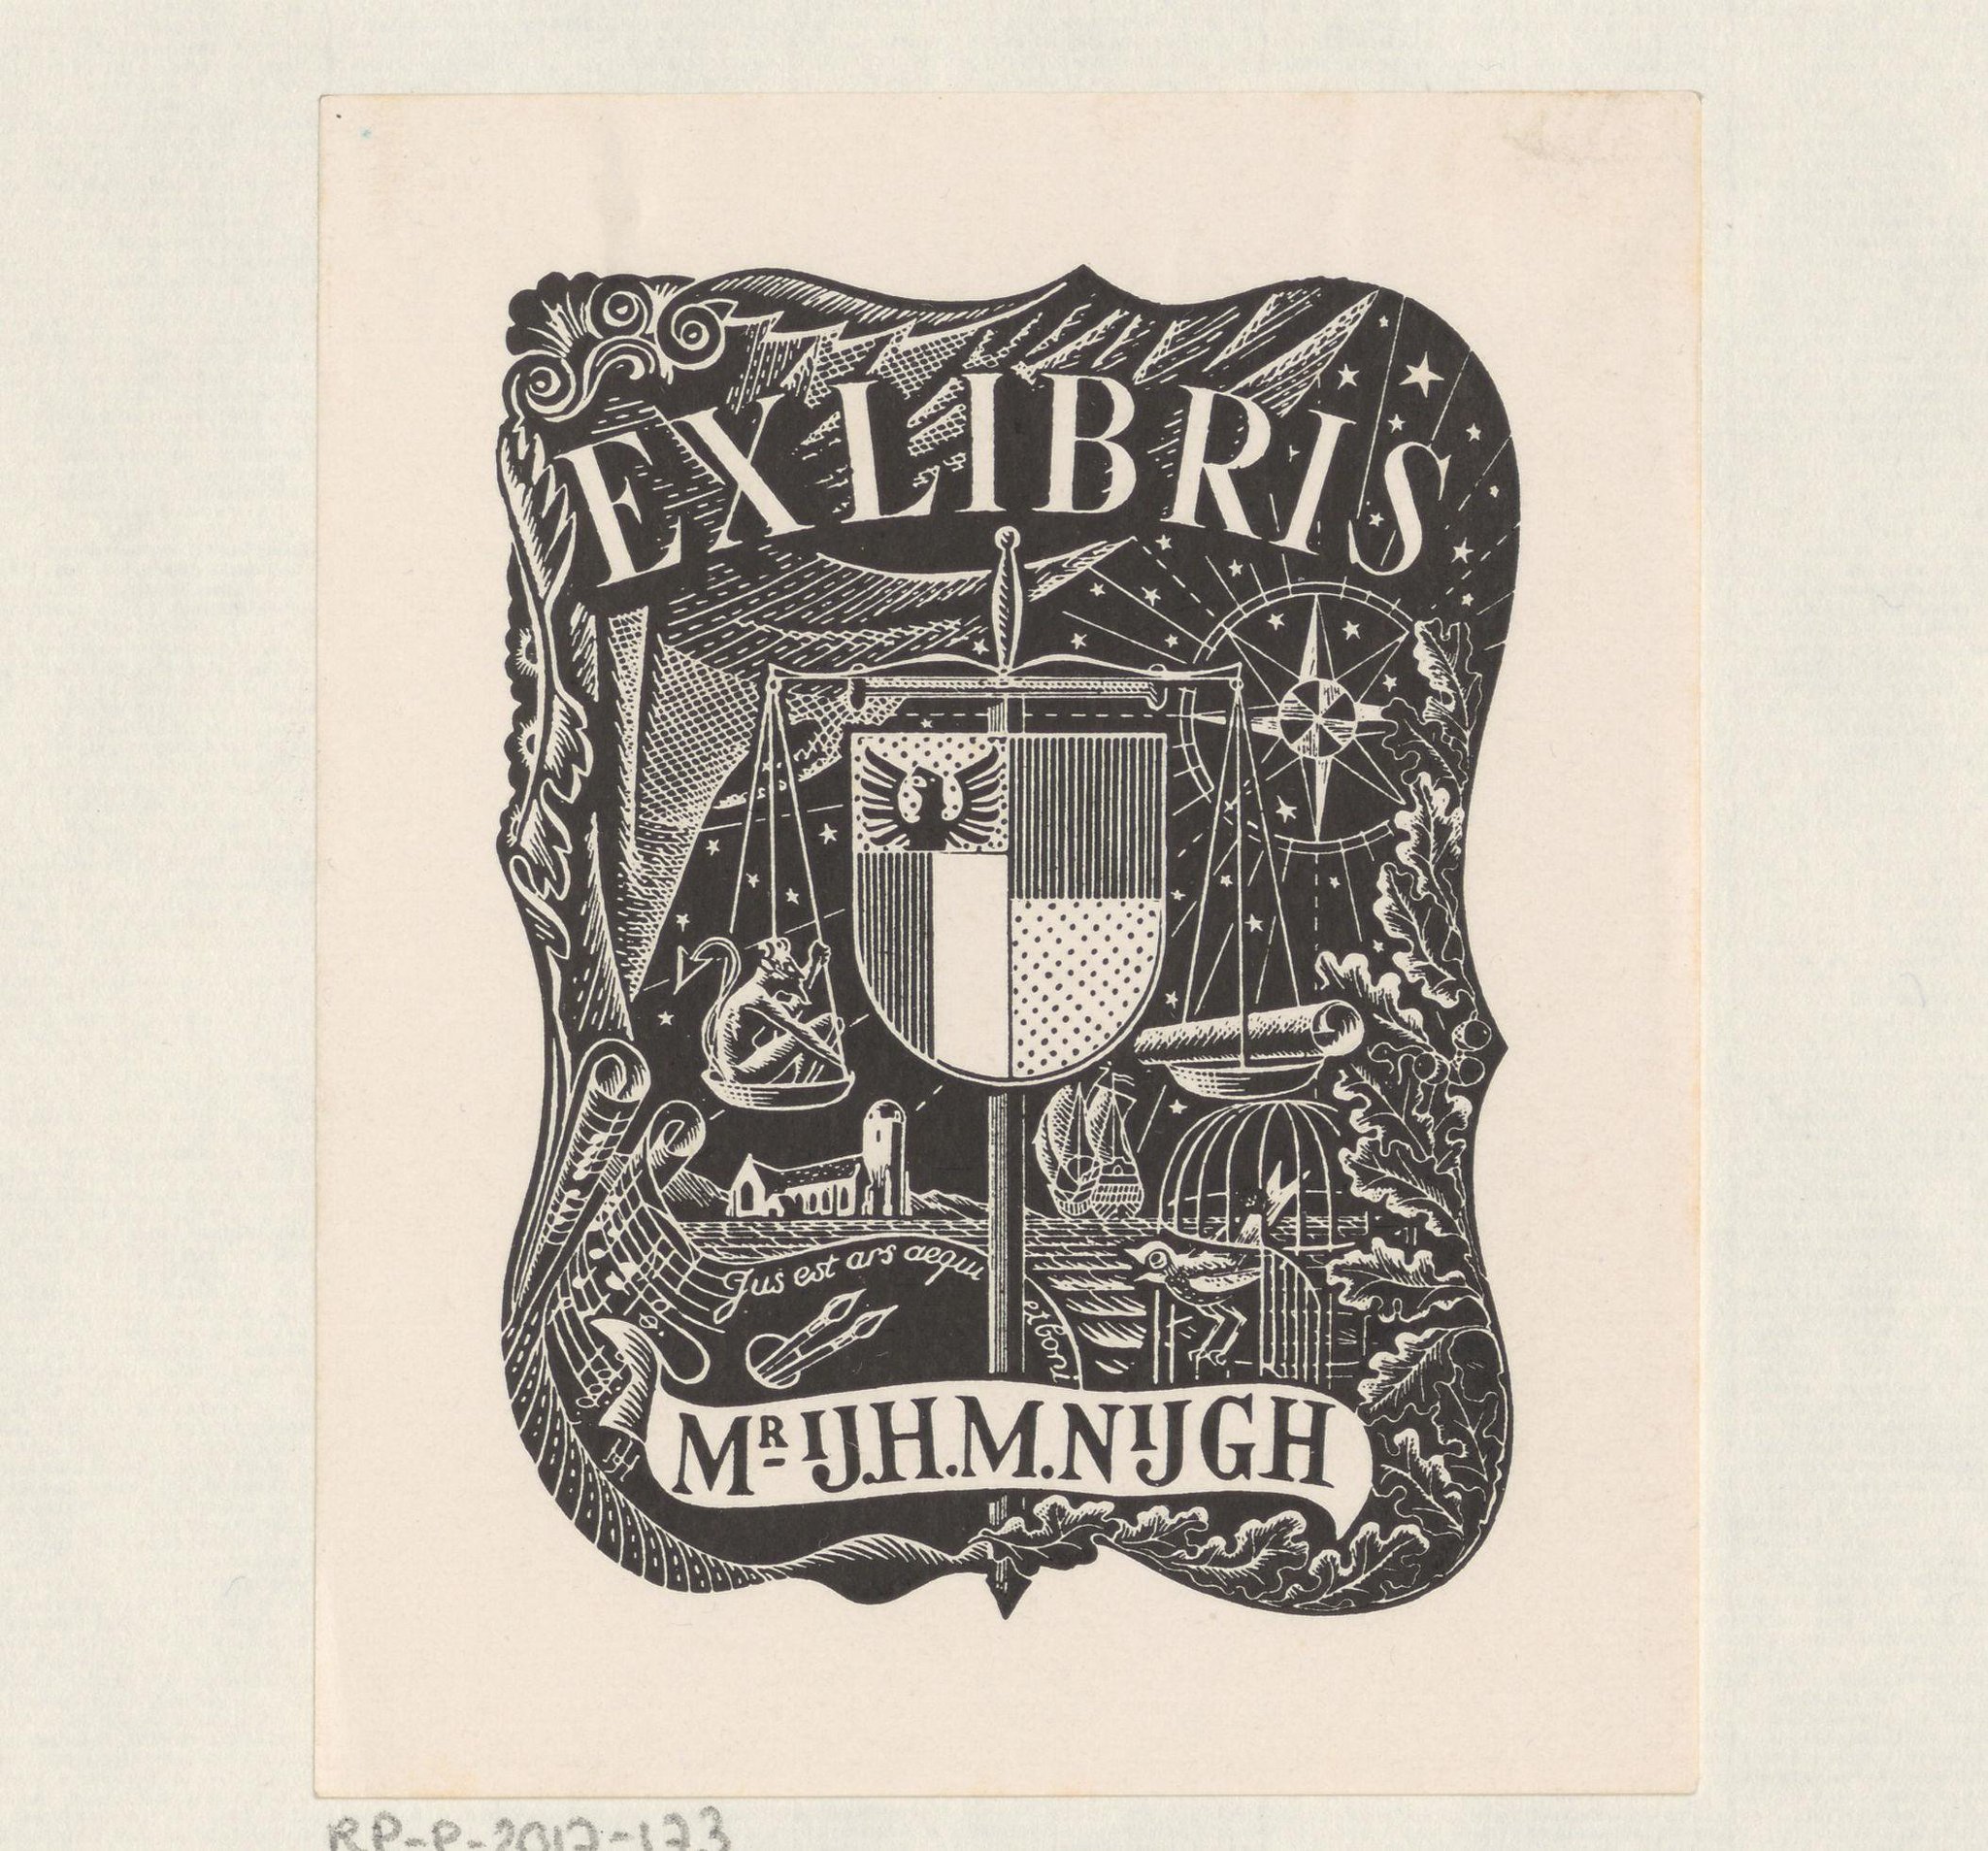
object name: bookplate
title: Ex libris van Y.H.M. Nijgh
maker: Anonymous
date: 1900-1999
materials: paper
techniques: printing block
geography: netherlands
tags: devil(s) and demons, palette, law and jurisprudence, compass, bird in a cage, armorial bearing, heraldry